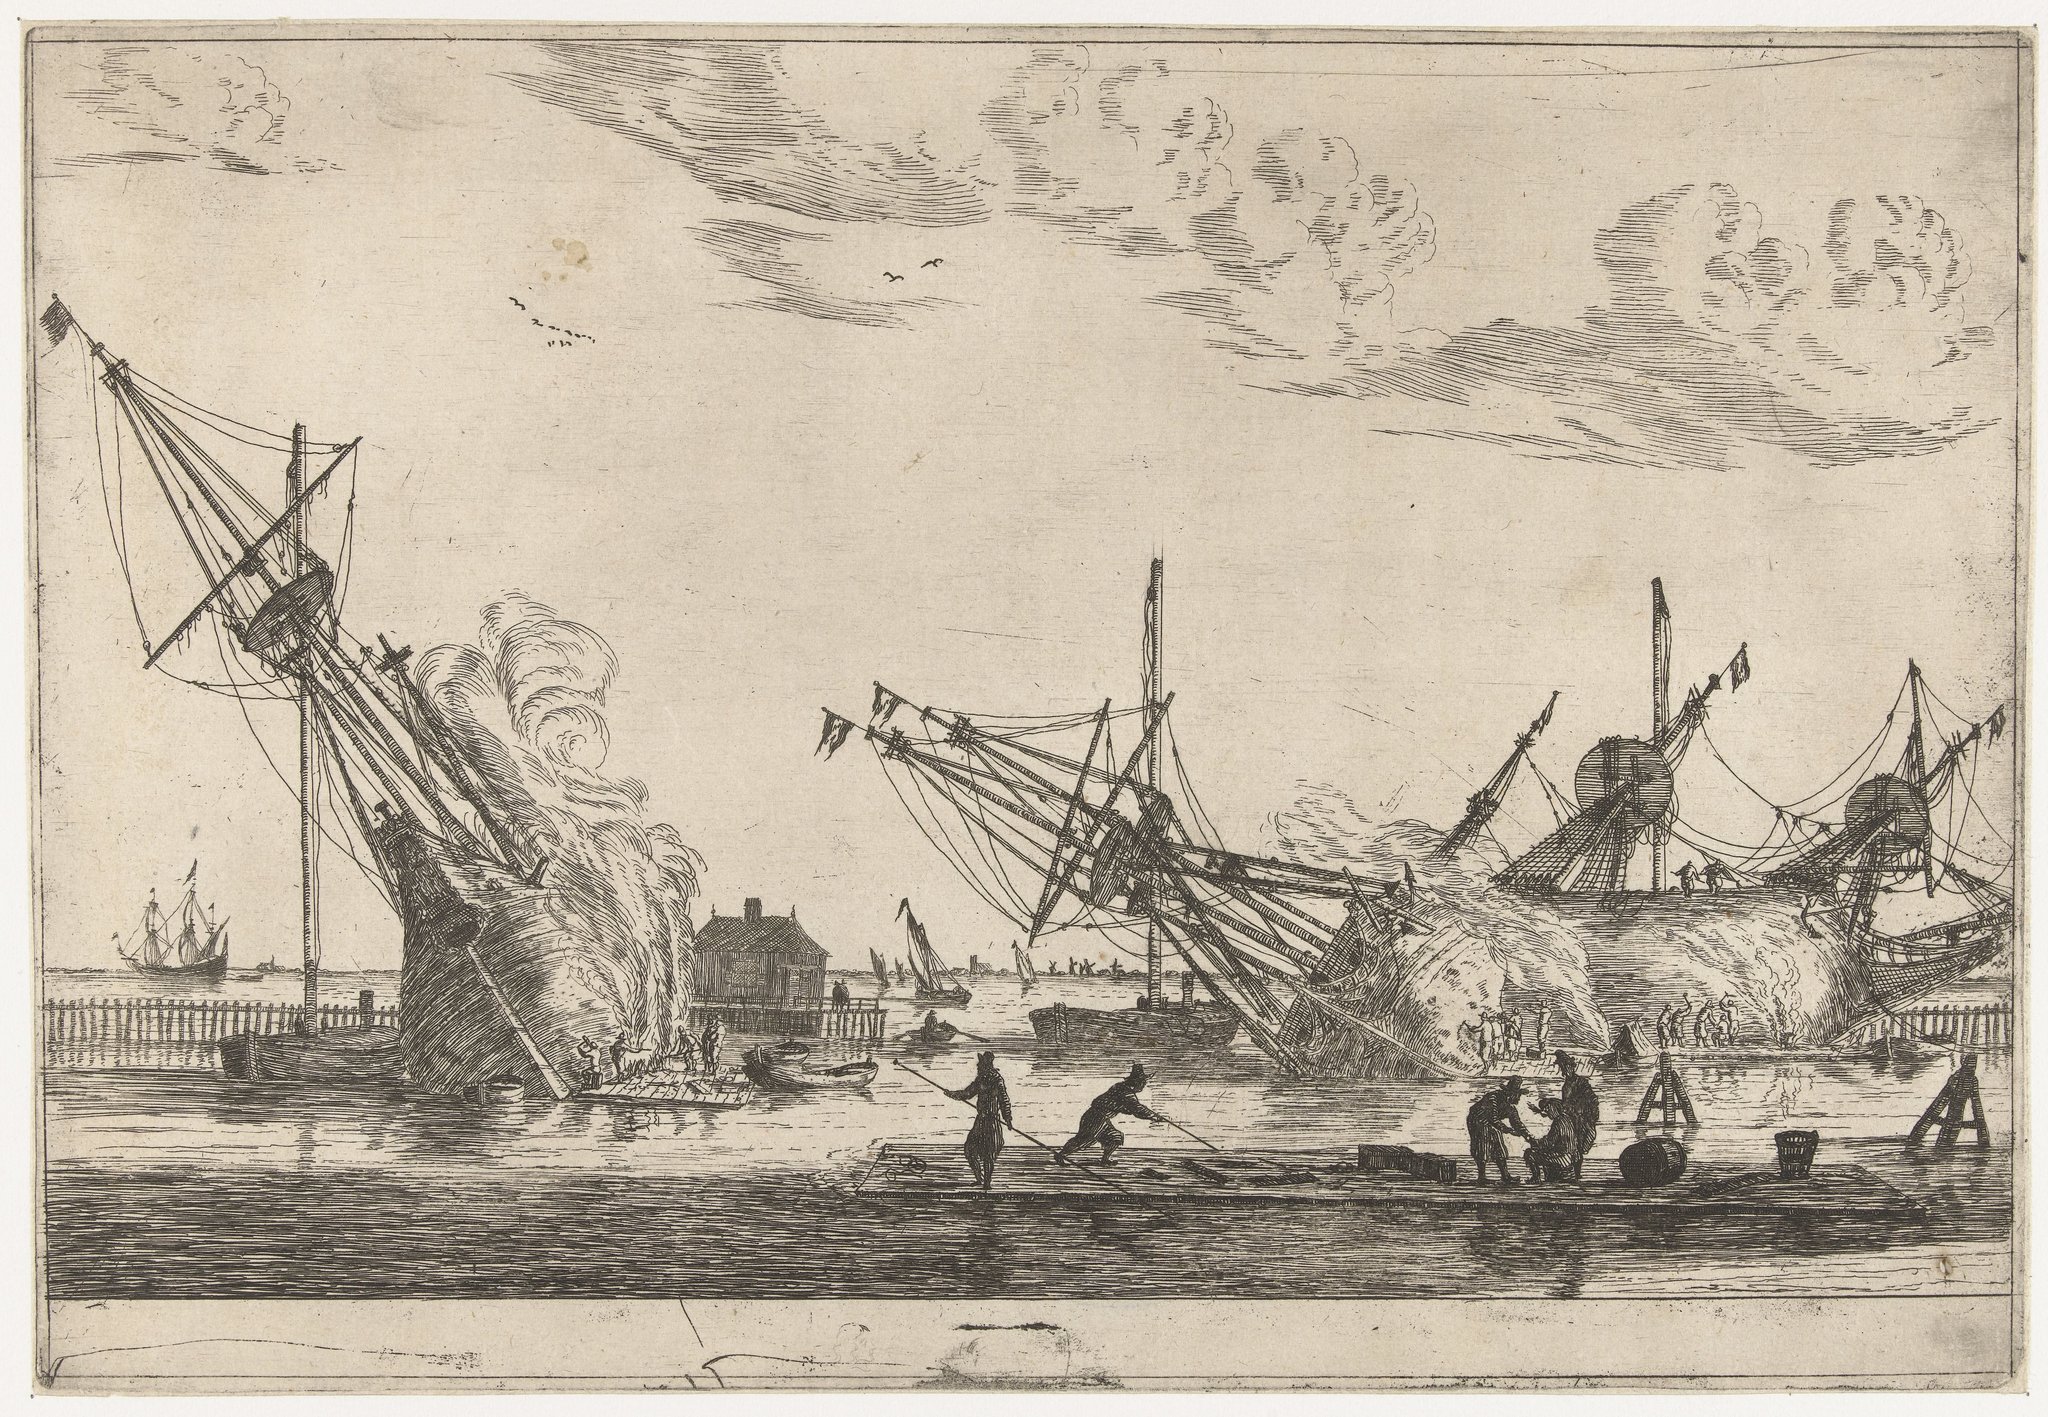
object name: print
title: Waterdichtmaken van de rompen van drie fluitschepen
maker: reinier nooms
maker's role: draughtsman, painter, print maker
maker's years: 1623-1664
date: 1650-1664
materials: paper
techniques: etching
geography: netherlands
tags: sailing-ship, sailing-boat (with name), repairing, caulking, careening (~ ship)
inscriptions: collector's mark: Lugt 2228a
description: Achter een golfbreker liggen drie gekield fluitschepen. Bij elk schip een drijvend vlot met mannen die werken aan het waterdichtmaken van de romp. Op de voorgrond een vlot met vijf mannen.